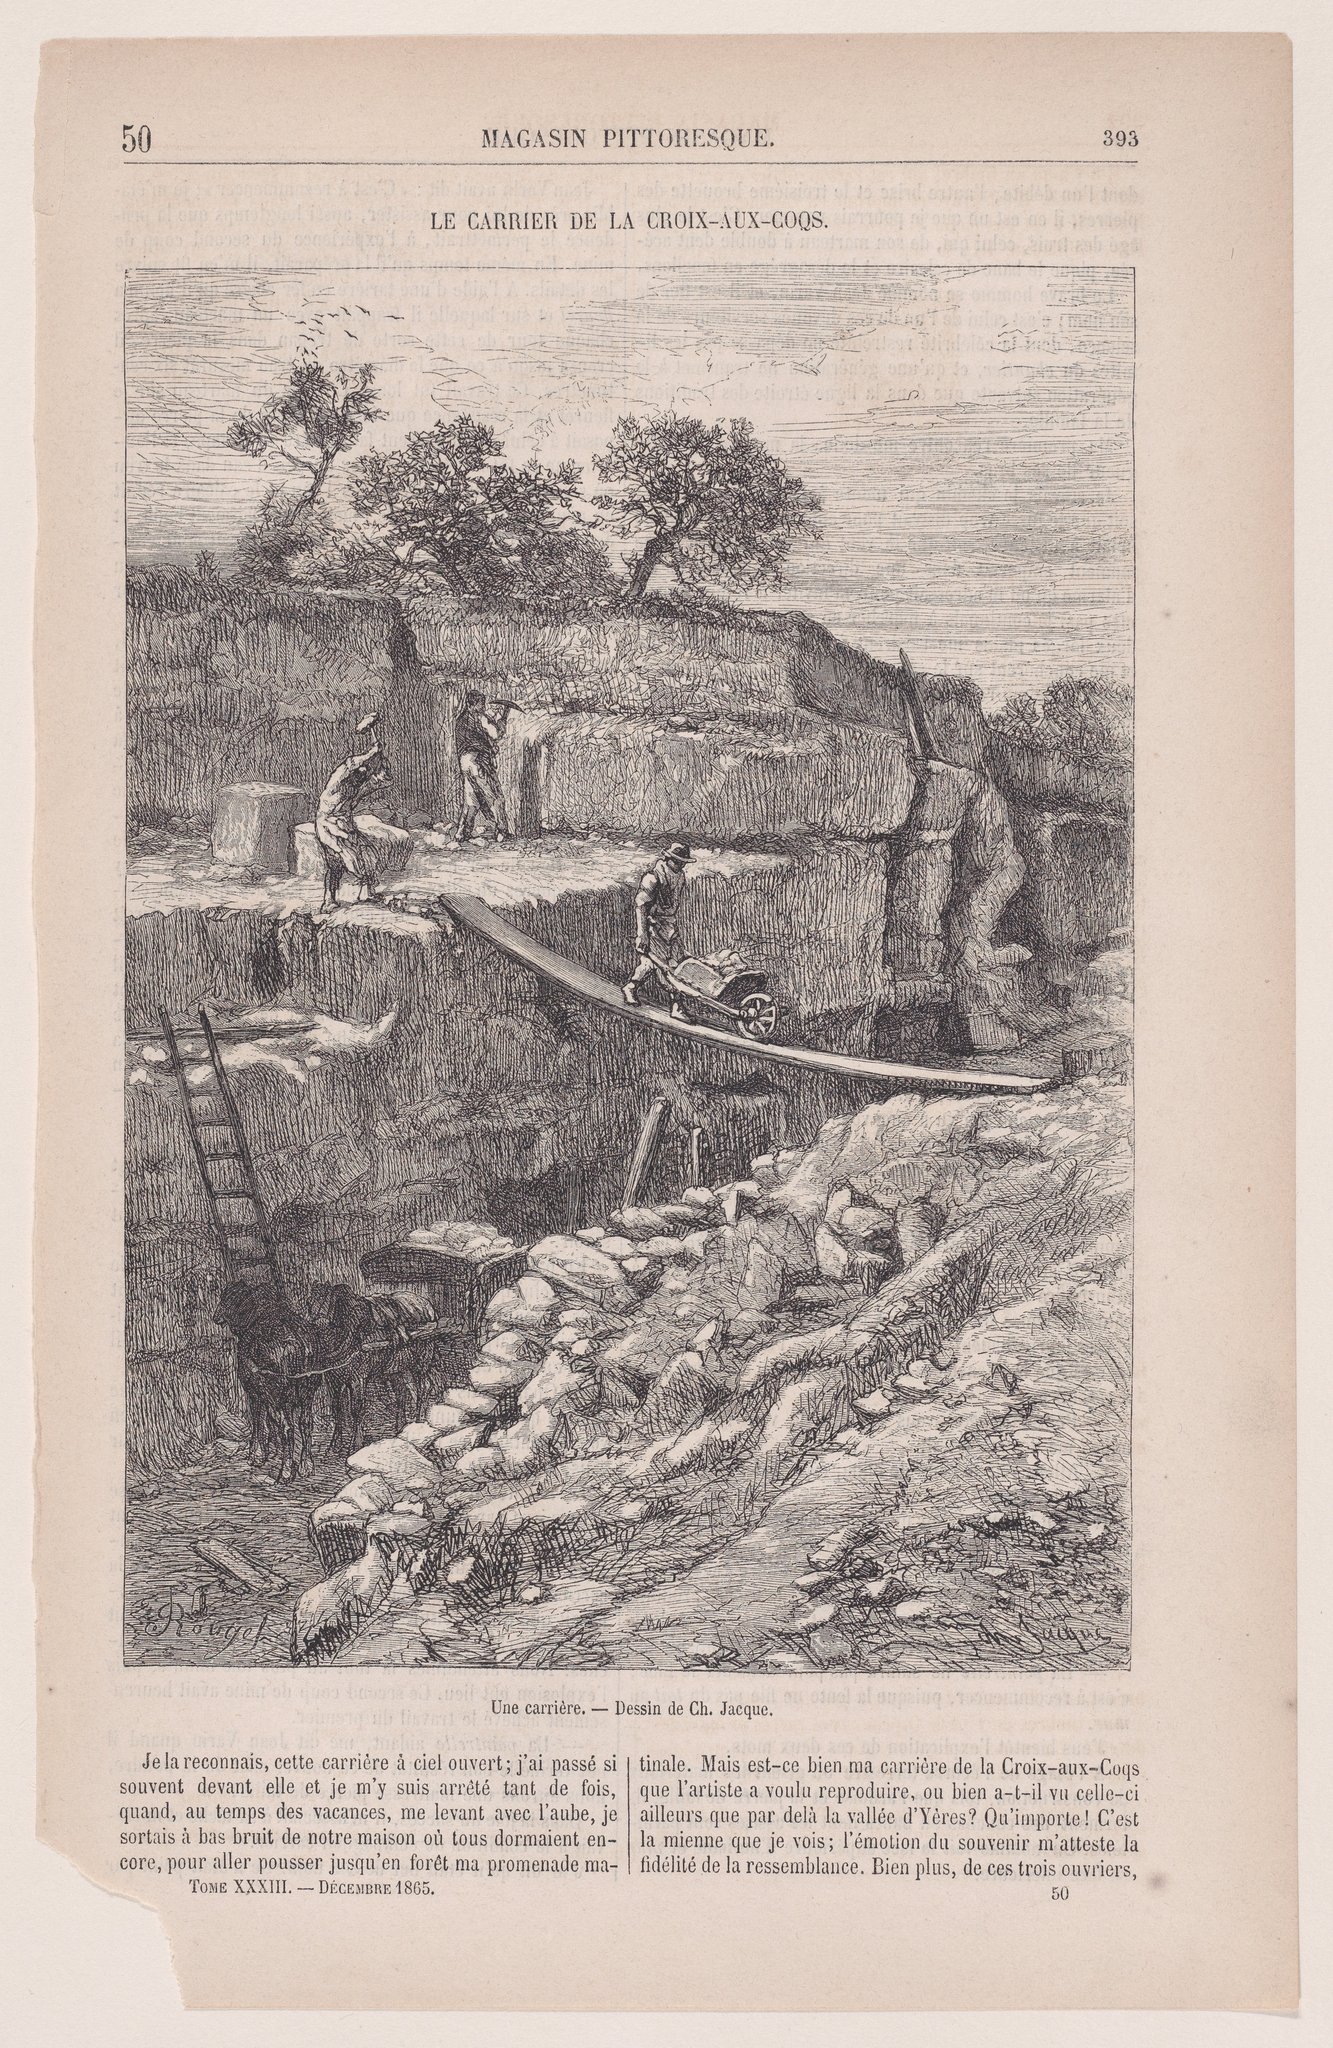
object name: print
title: Une Carrière, from "Le Magasin Pittoresque"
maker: charles émile jacque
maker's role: artist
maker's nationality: french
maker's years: 1813-1894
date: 1852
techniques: engraving